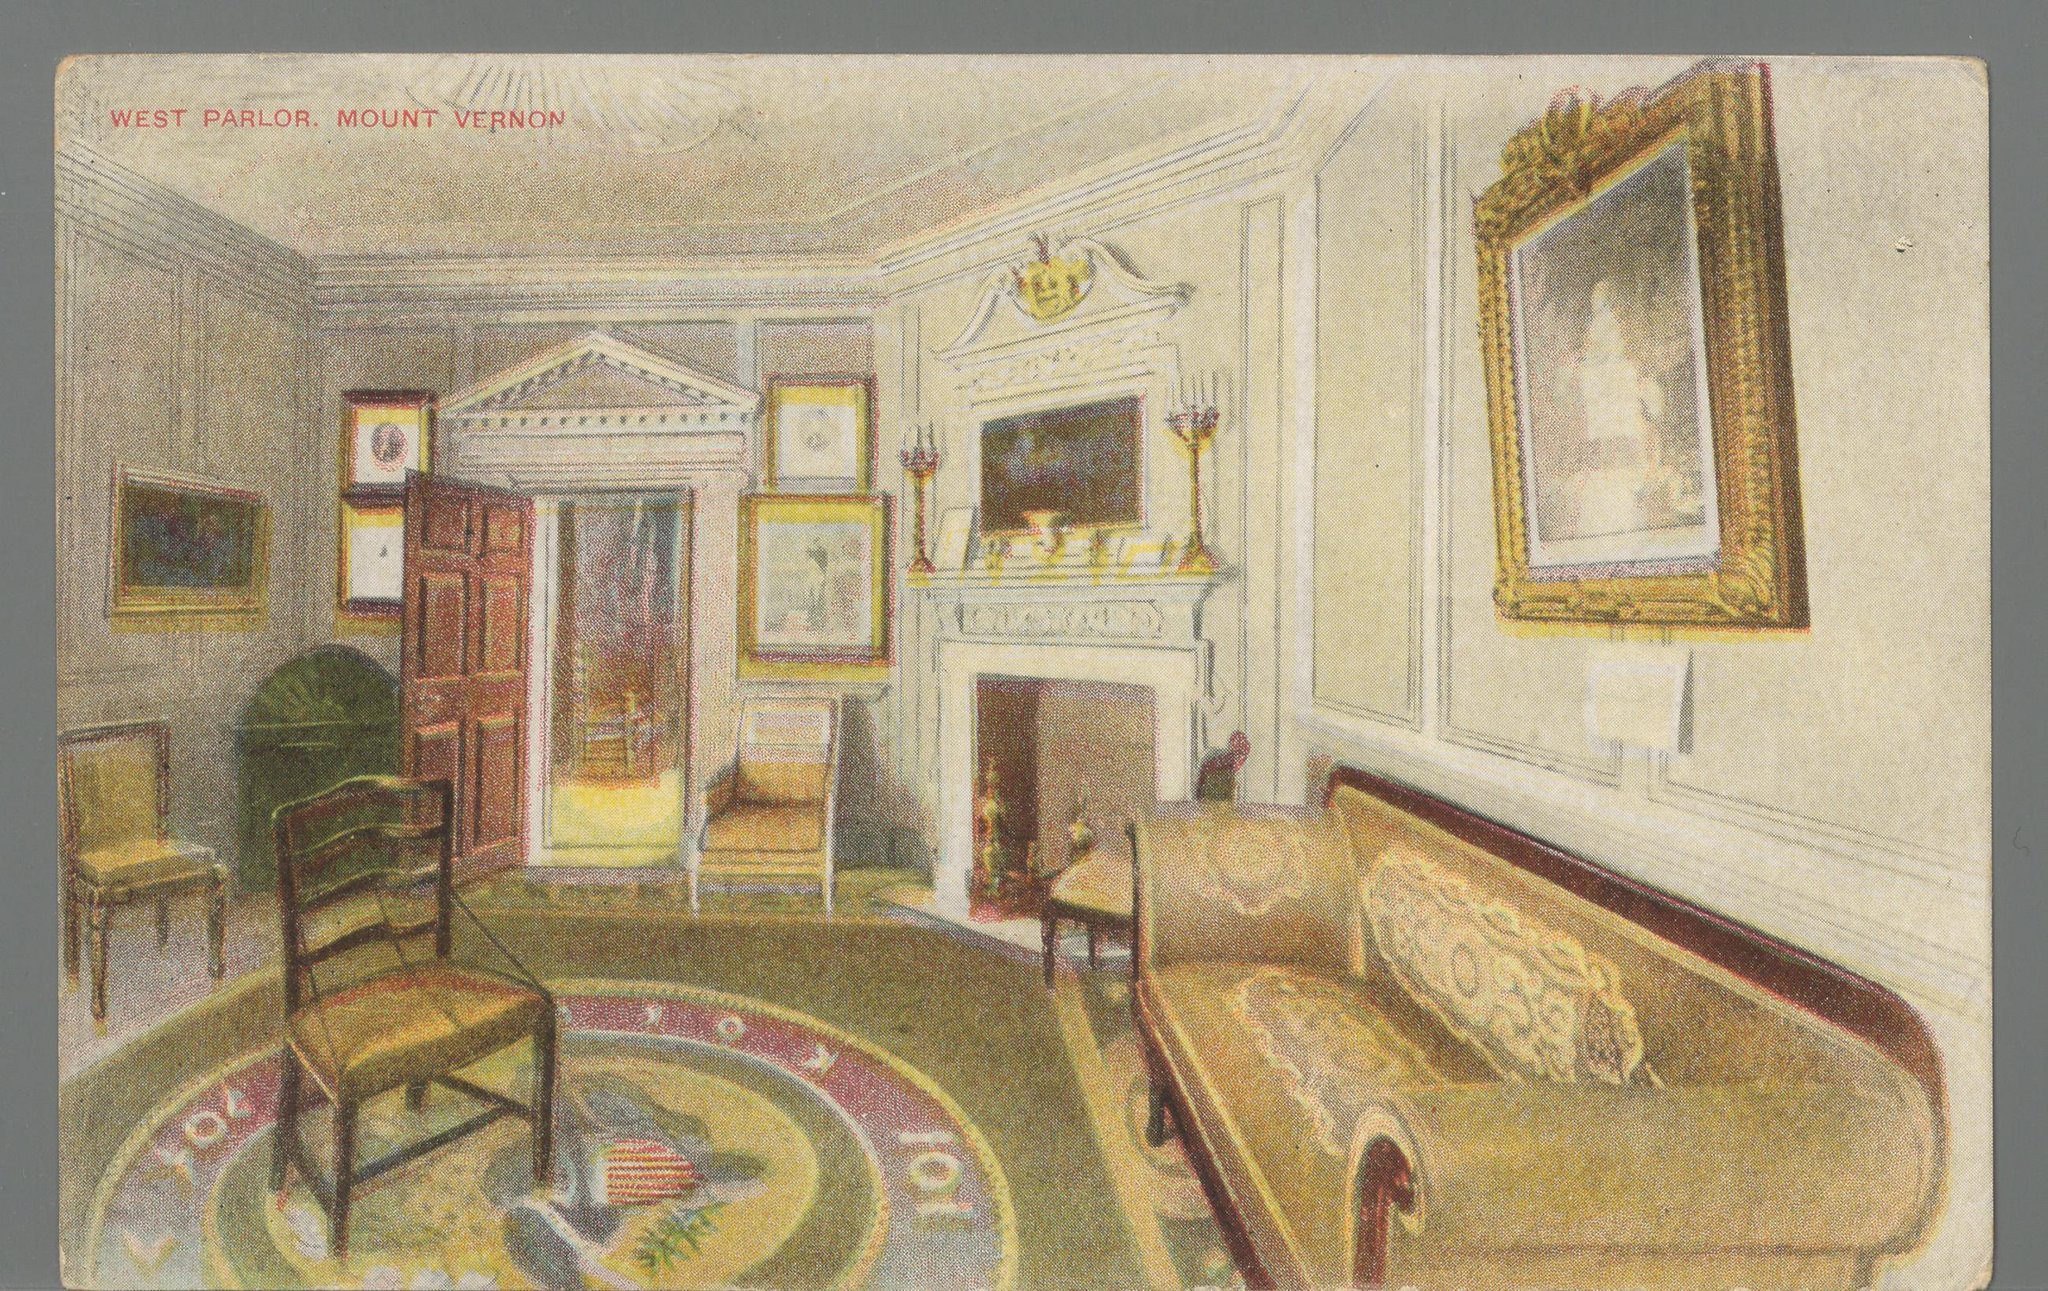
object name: photomechanical print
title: West parlor. Mount Vernon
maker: Anonymous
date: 1907-1930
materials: cardboard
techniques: lithograph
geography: new york city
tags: interior of the house